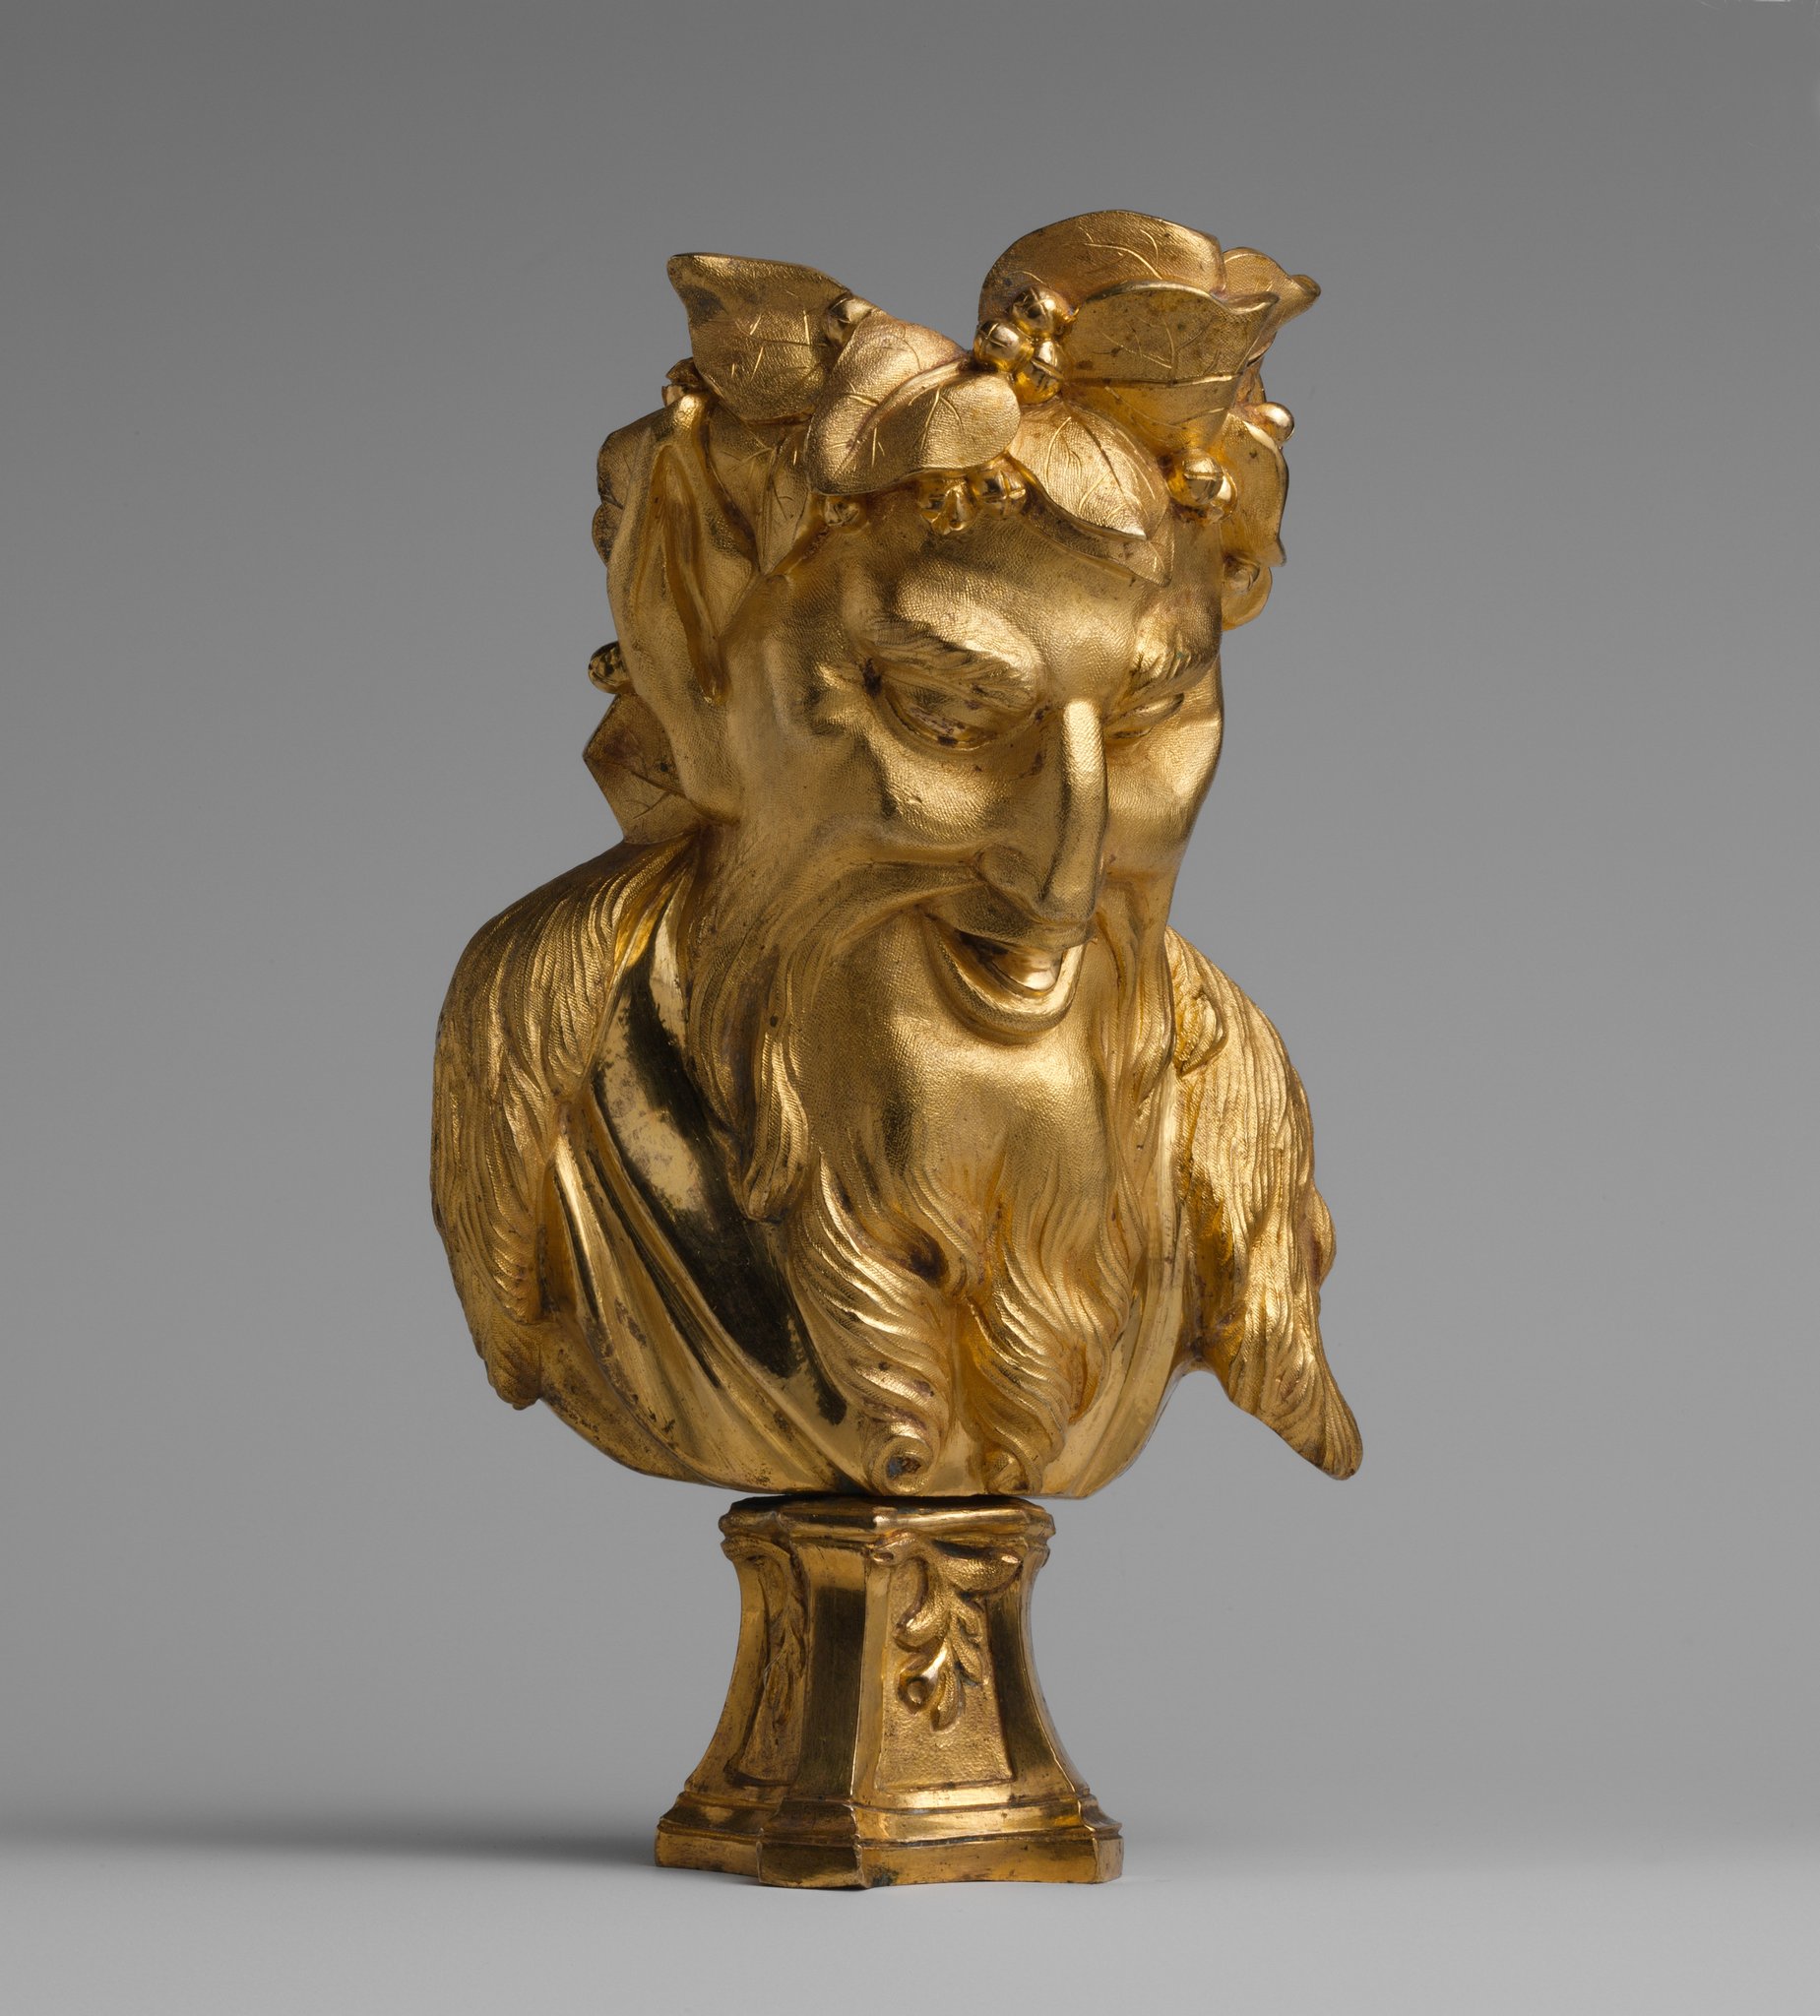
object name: pedestal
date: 1601-1800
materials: gilt bronze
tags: heads,satyrs